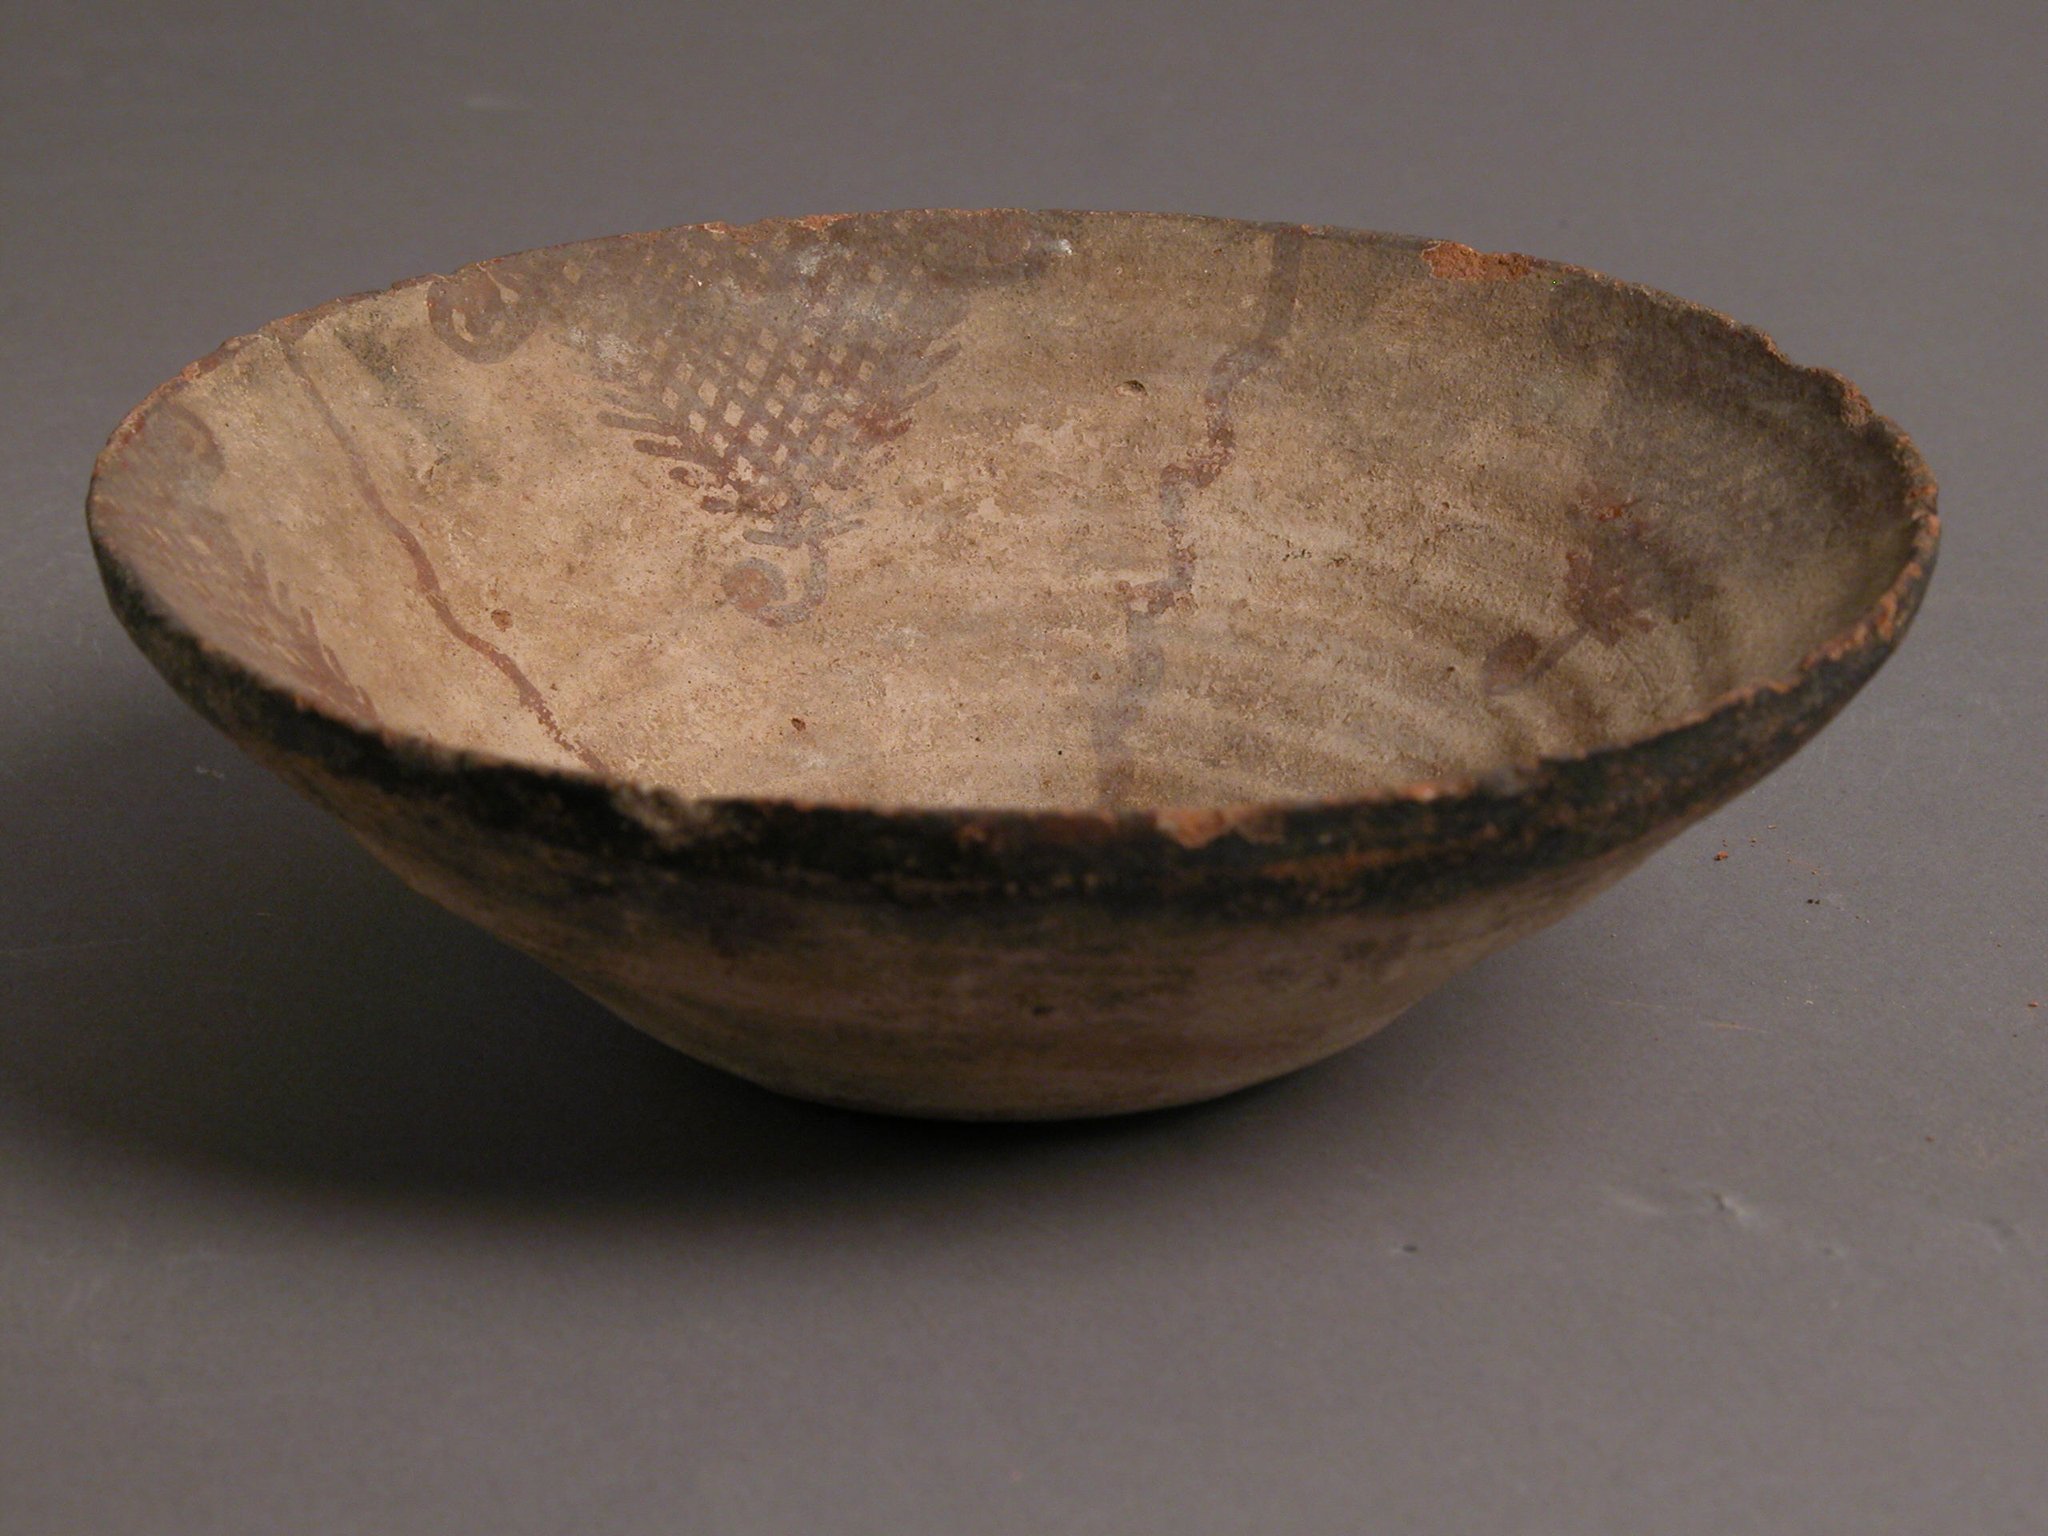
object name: bowl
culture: coptic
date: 301-700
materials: earthenware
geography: egypt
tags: bowls